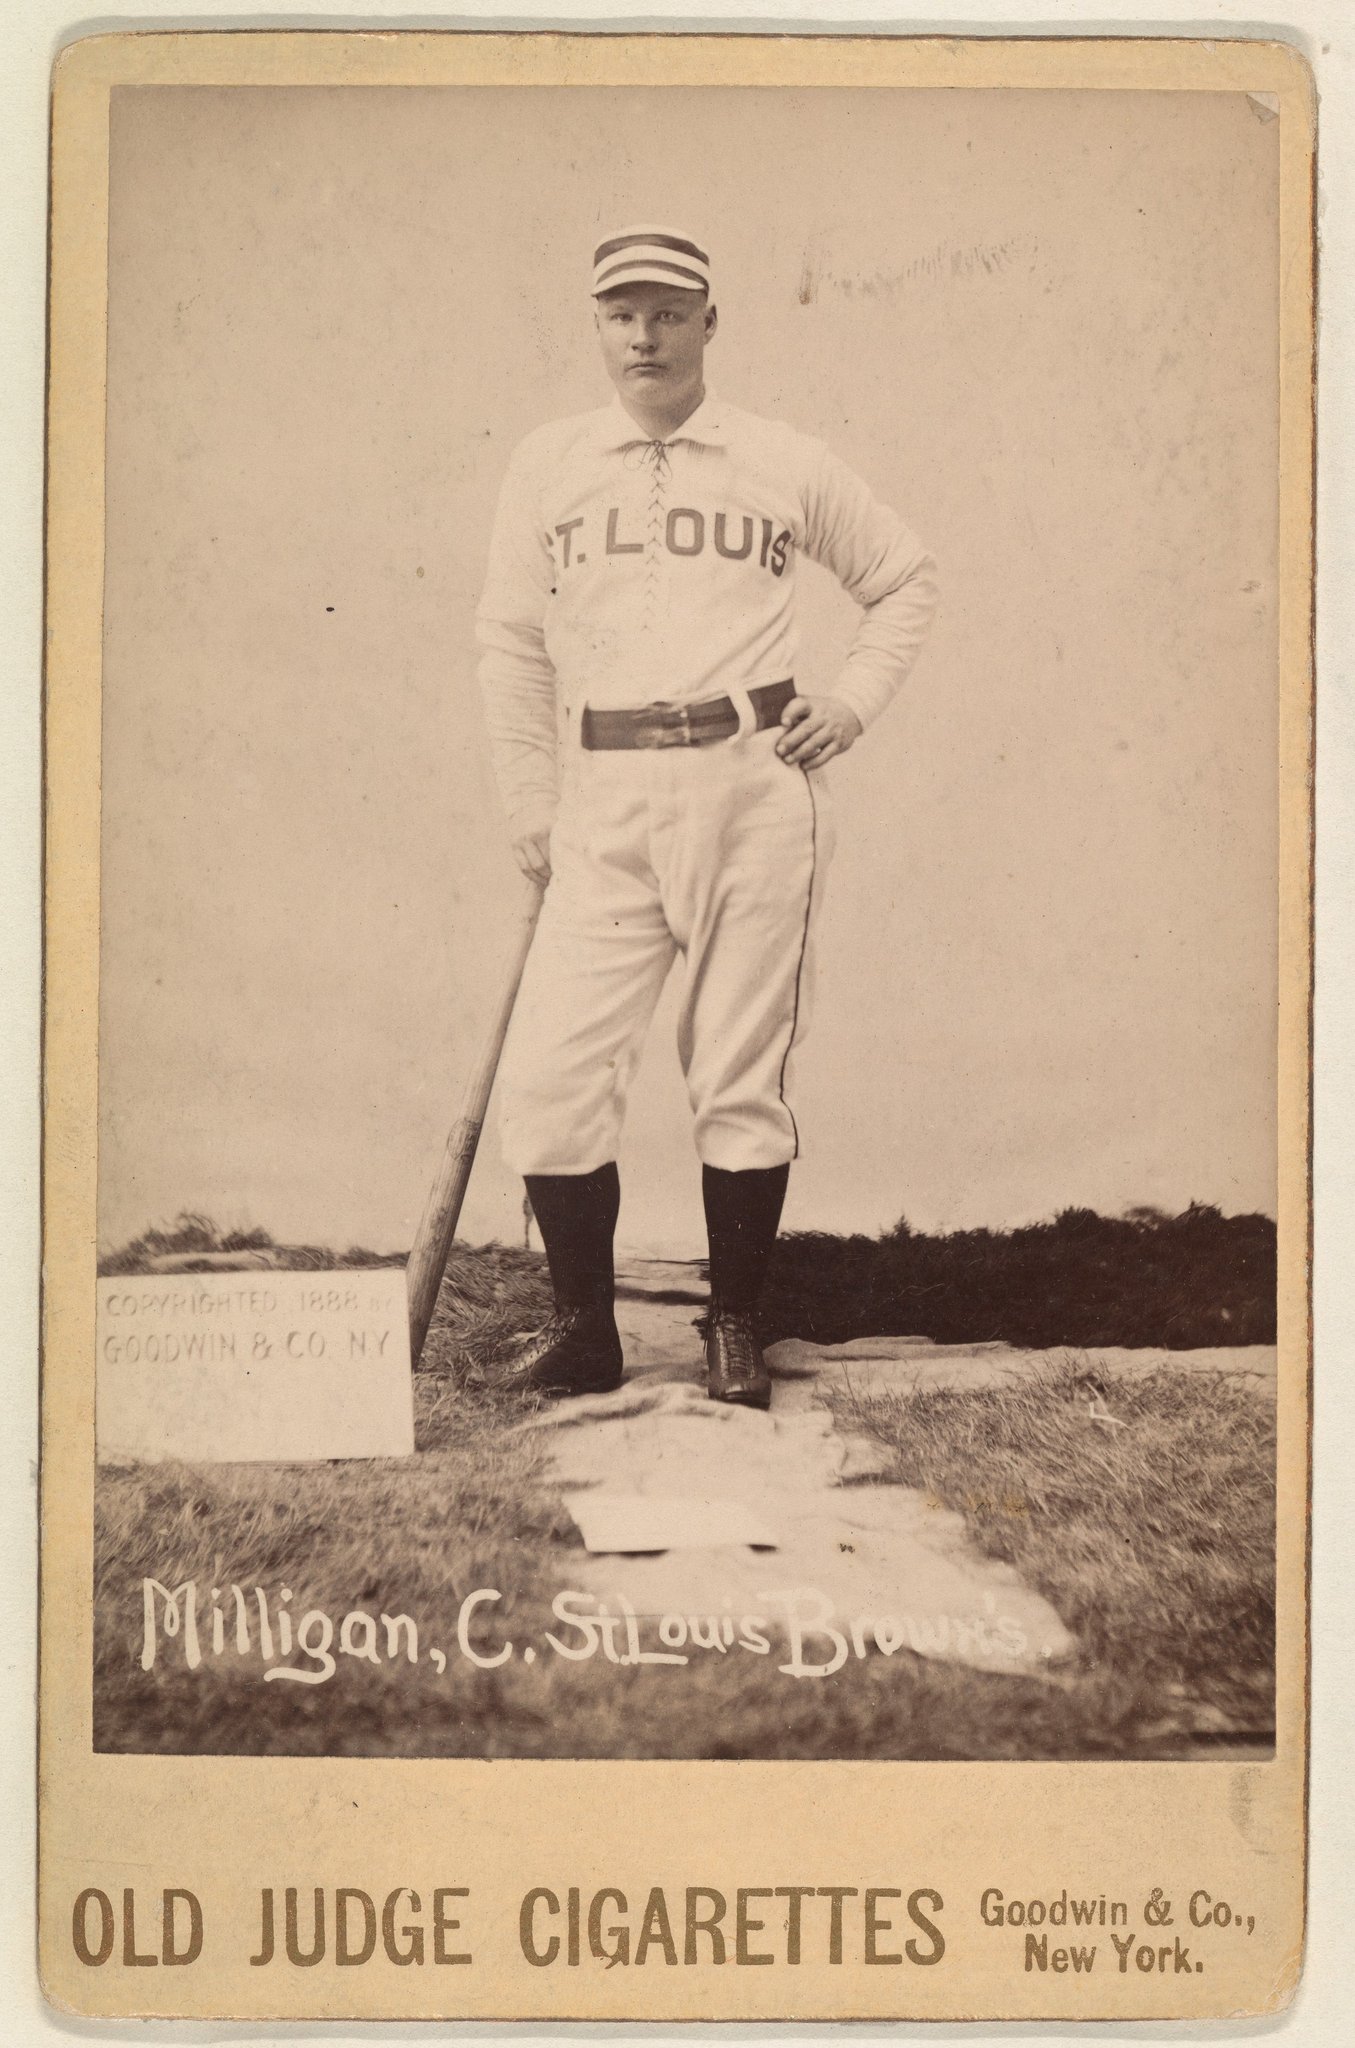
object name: baseball card, photograph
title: Milligan, Catcher, St. Louis Browns, from the series Old Judge Cigarettes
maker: goodwin & company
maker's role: publisher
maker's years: 1850-1950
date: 1888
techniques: albumen print, photography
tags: men,portraits,baseball,athletes